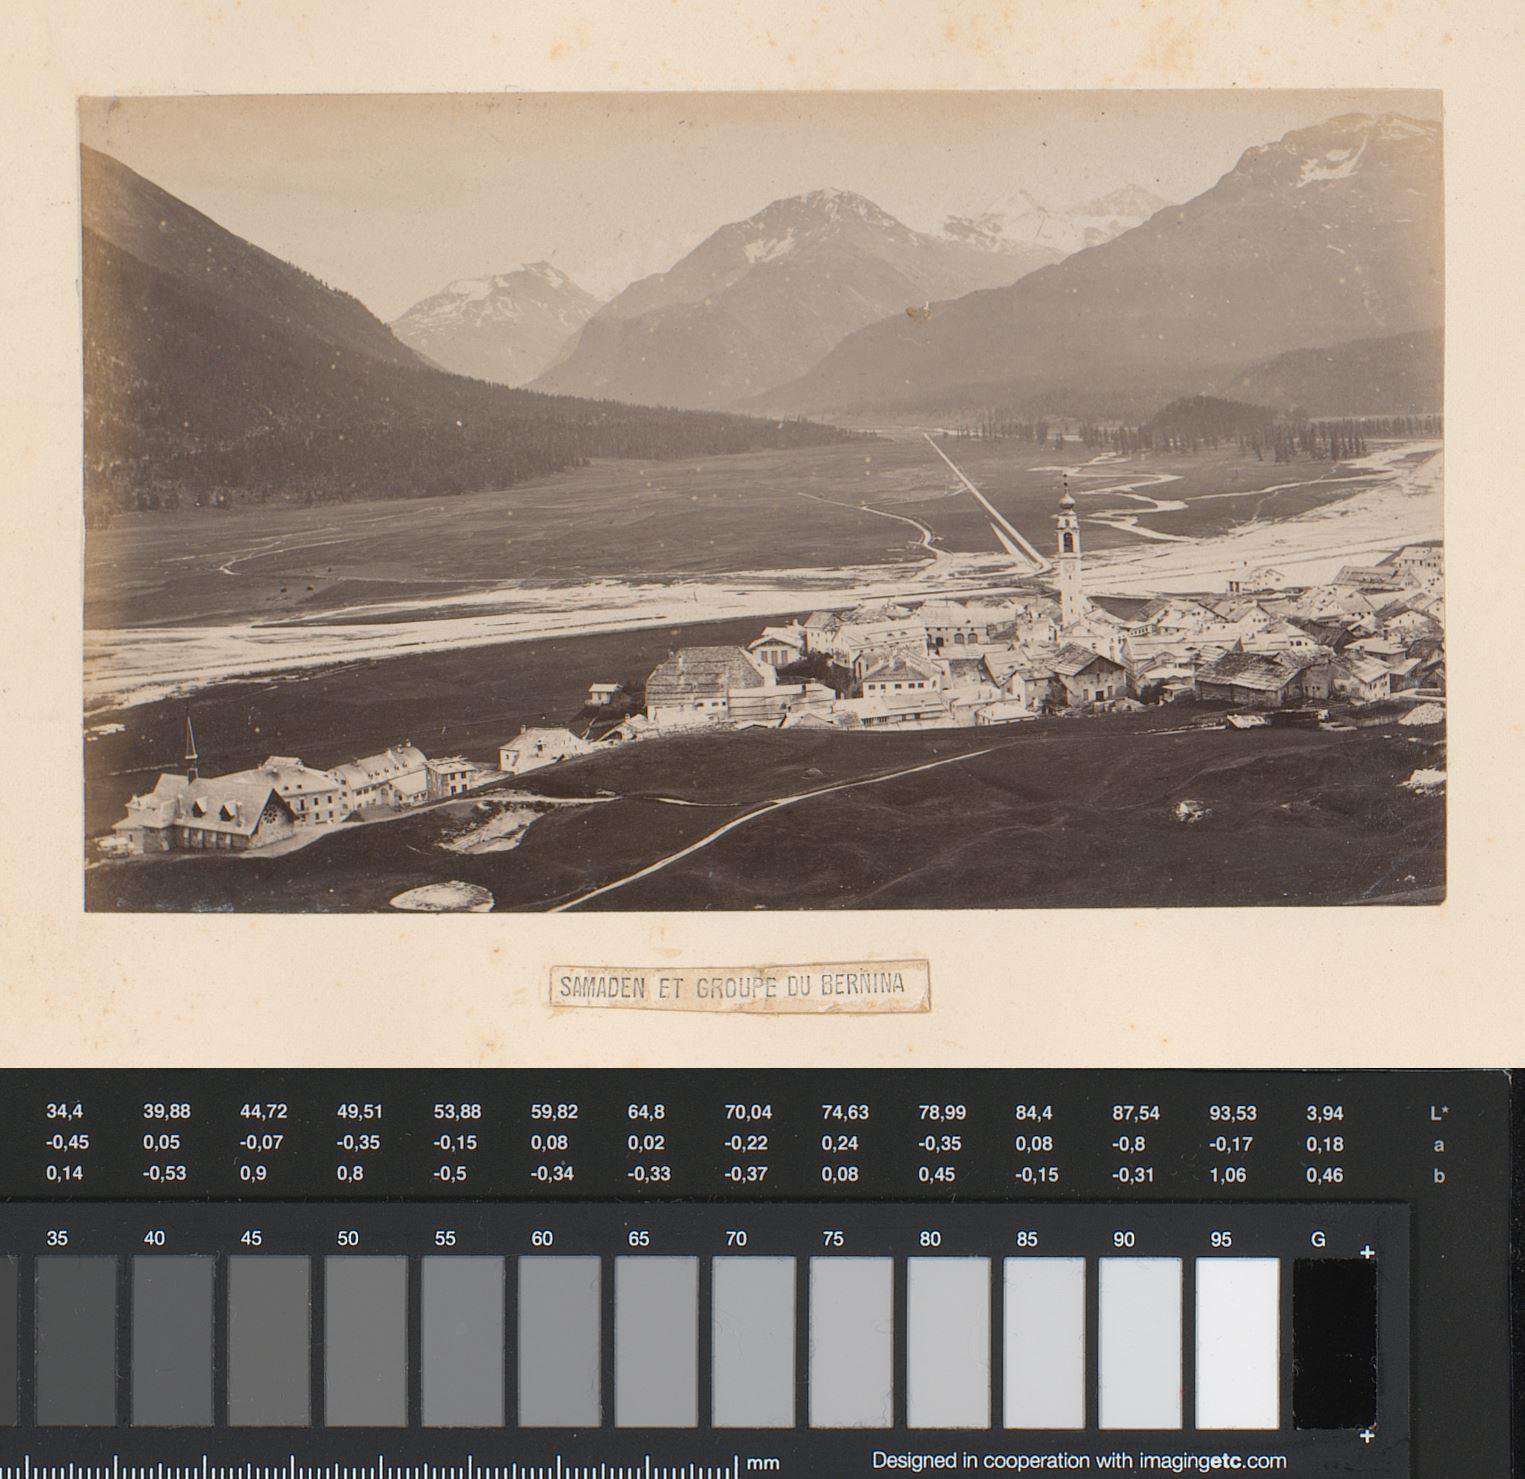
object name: photograph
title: Samaden et Groupe du Bernina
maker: Anonymous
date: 1860-1890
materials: paper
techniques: albumen print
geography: samedan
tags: prospect of village, silhouette of village, dale, valley, mountains